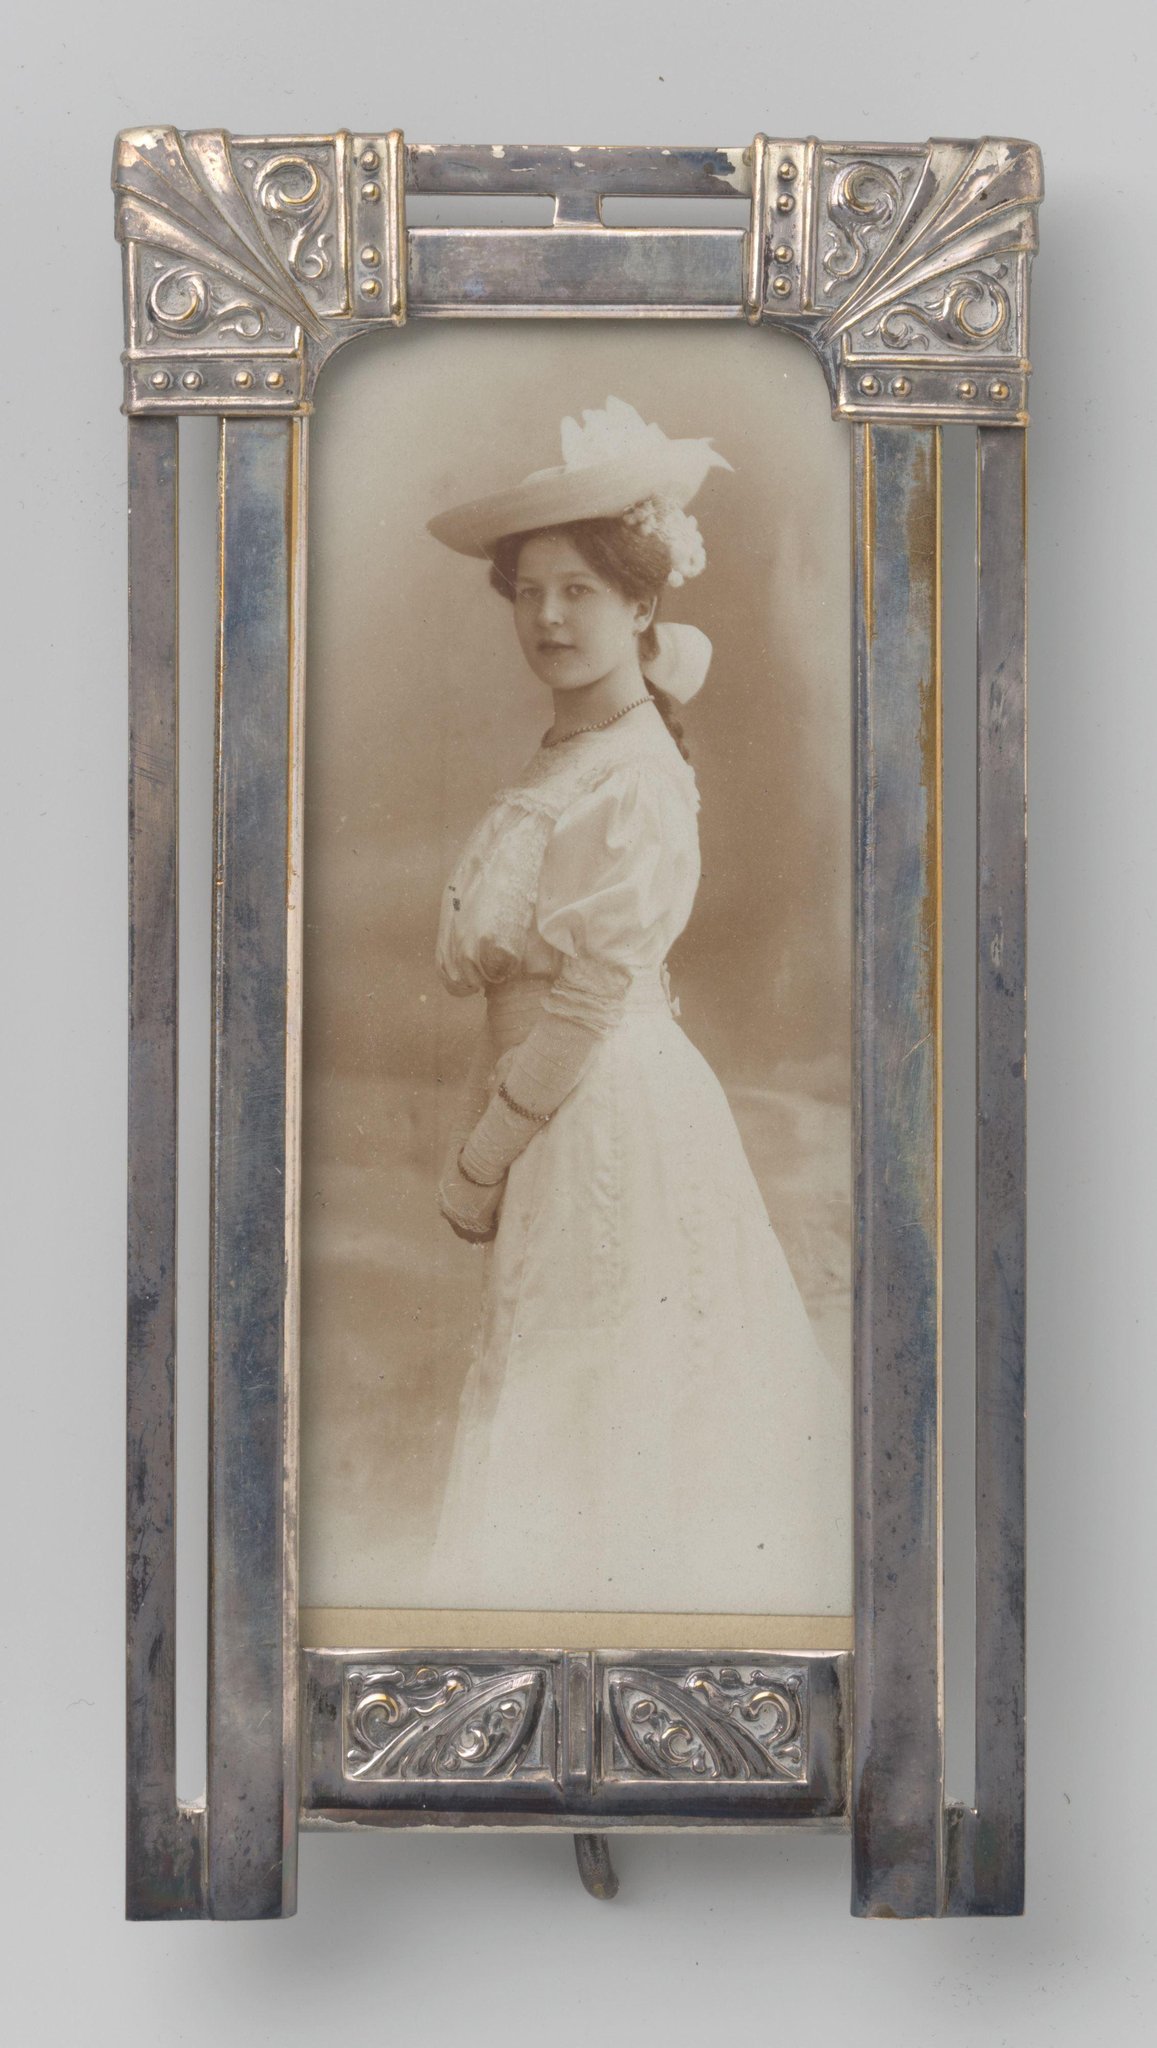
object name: photograph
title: Portret van een onbekende jonge vrouw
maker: Anonymous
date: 1880-1900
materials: paper, cardboard, glass, metal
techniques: collodion silver print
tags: adolescent, young woman, maiden, anonymous historical person portrayed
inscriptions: number: ‘33 IV’